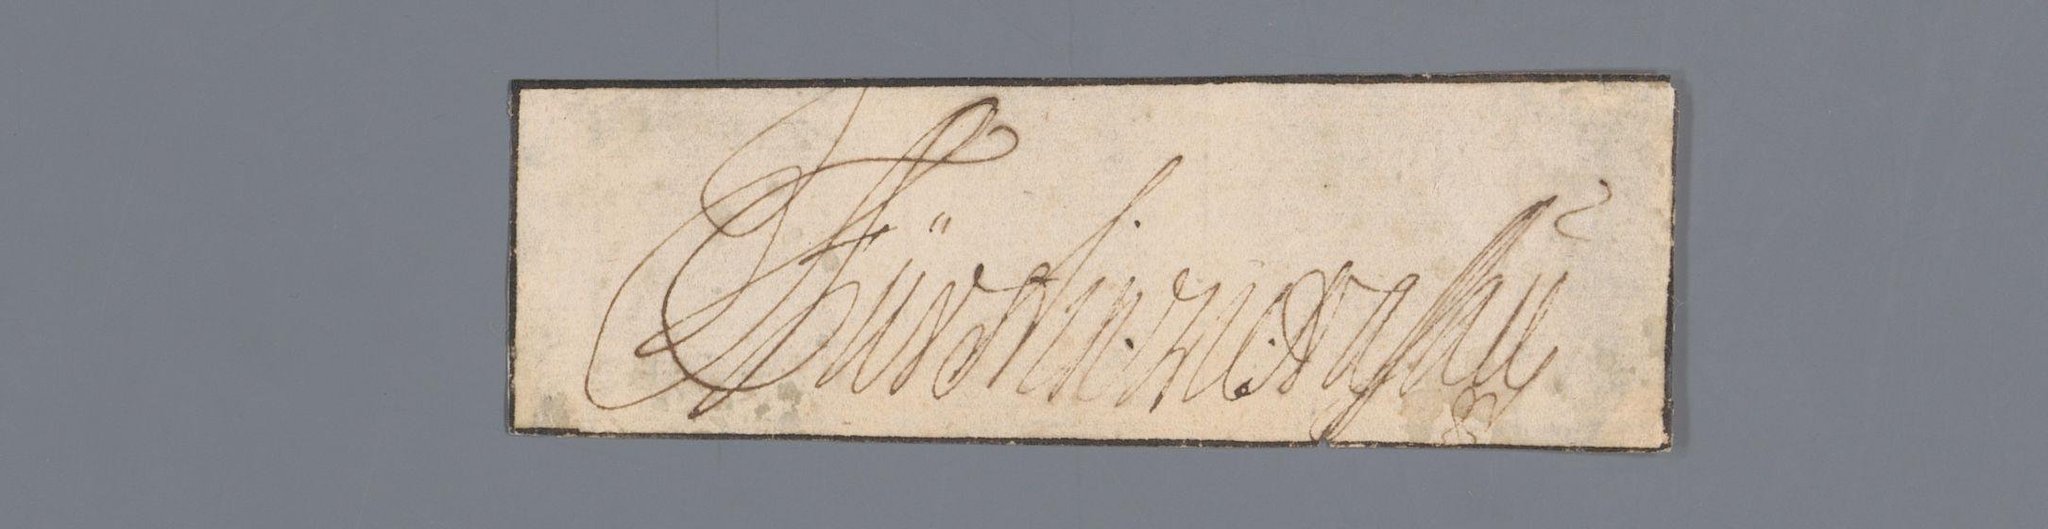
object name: document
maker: hendrik casimir ii graaf van nassau-dietz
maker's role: stadhouder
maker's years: 1657-1696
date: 1650-1700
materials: ink, paper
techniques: writing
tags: hendrik casimir ii graaf van nassau-dietz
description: Handtekening in bruine inkt (van Hendrik Casimir II) op uitgeknipt blaadje papier. Gesigneerd: Fùrst zu Nassau.